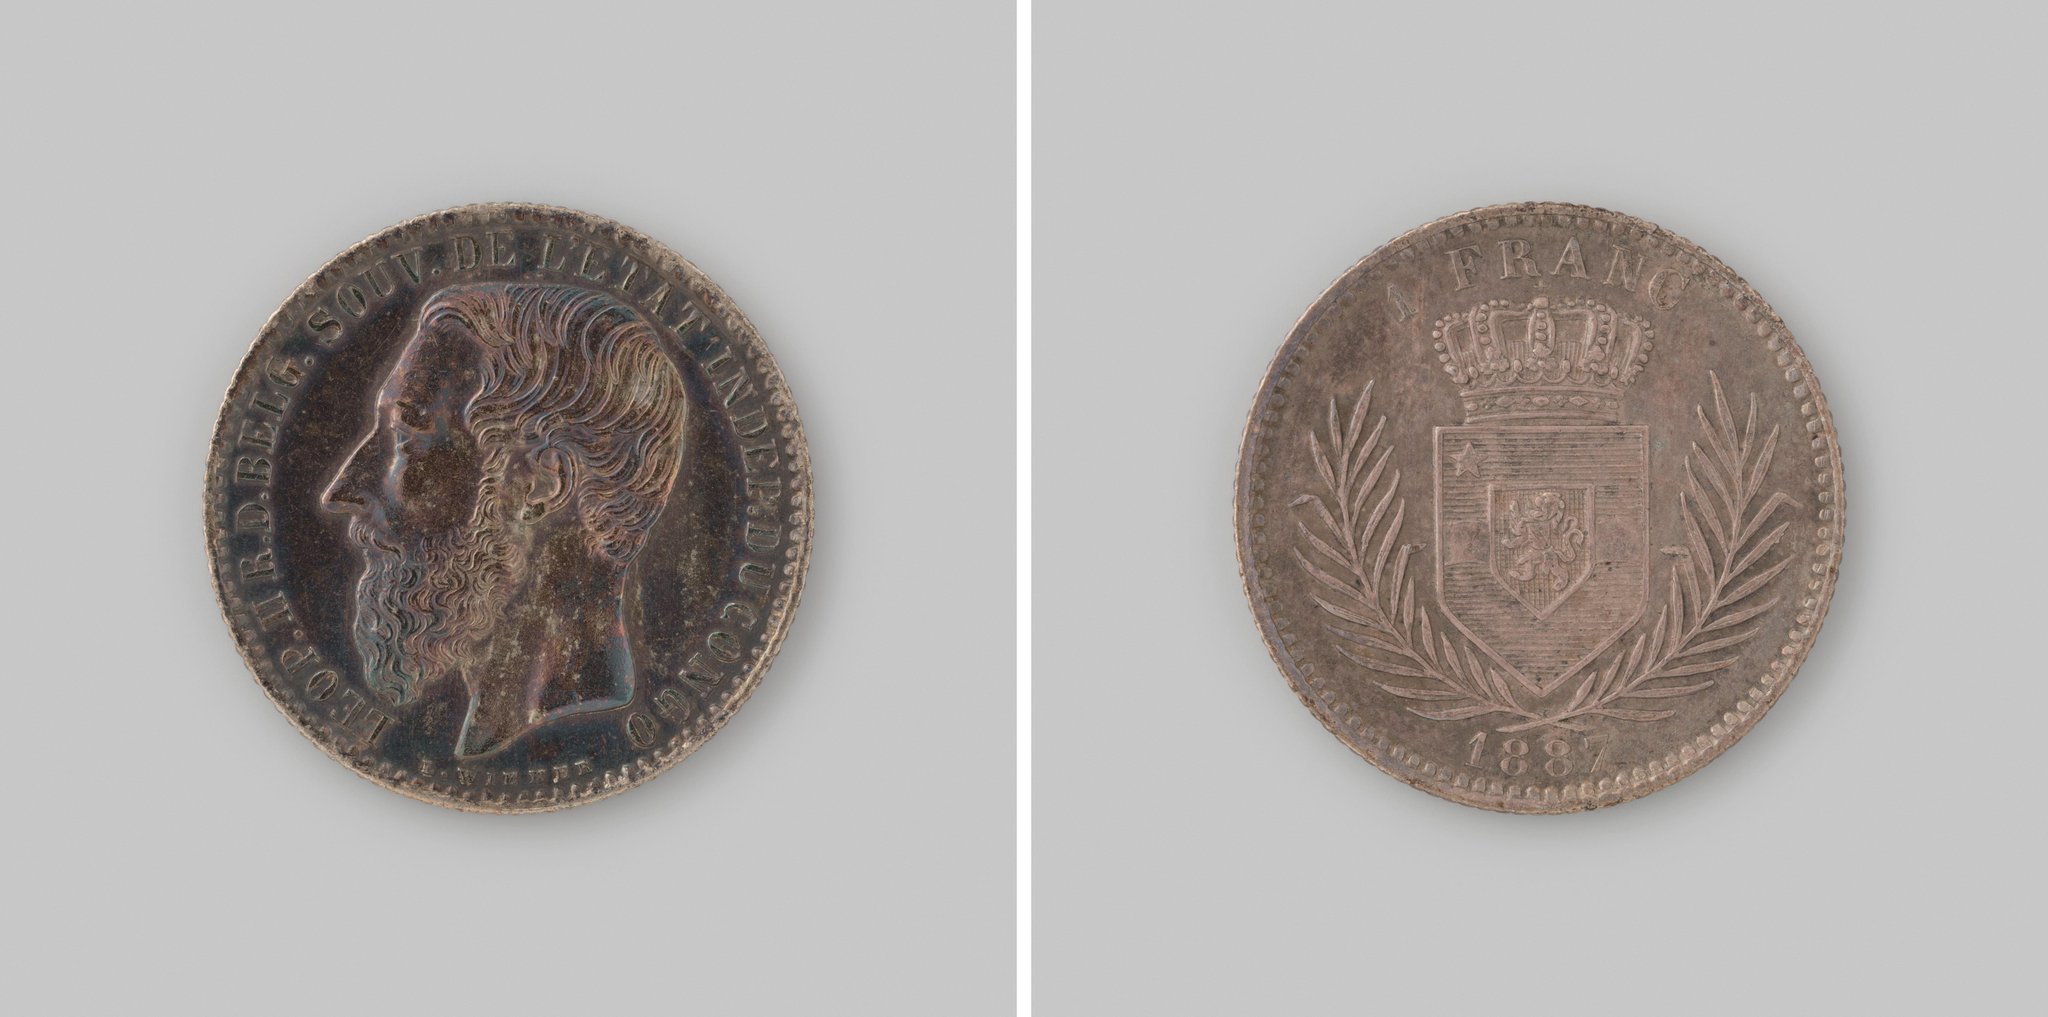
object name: coin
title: Congo Vrijstaat, koning Leopold II van België als soeverein, franc, 1887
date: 1887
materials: silver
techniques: striking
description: Zilveren munt. Voorzijde: hoofd van de soeverein naar links. Keerzijde: tussen twee samengebonden takken gekroond wapenschild. Waarde-aanduiding in omschrift bovenaan en jaartal onderaan.